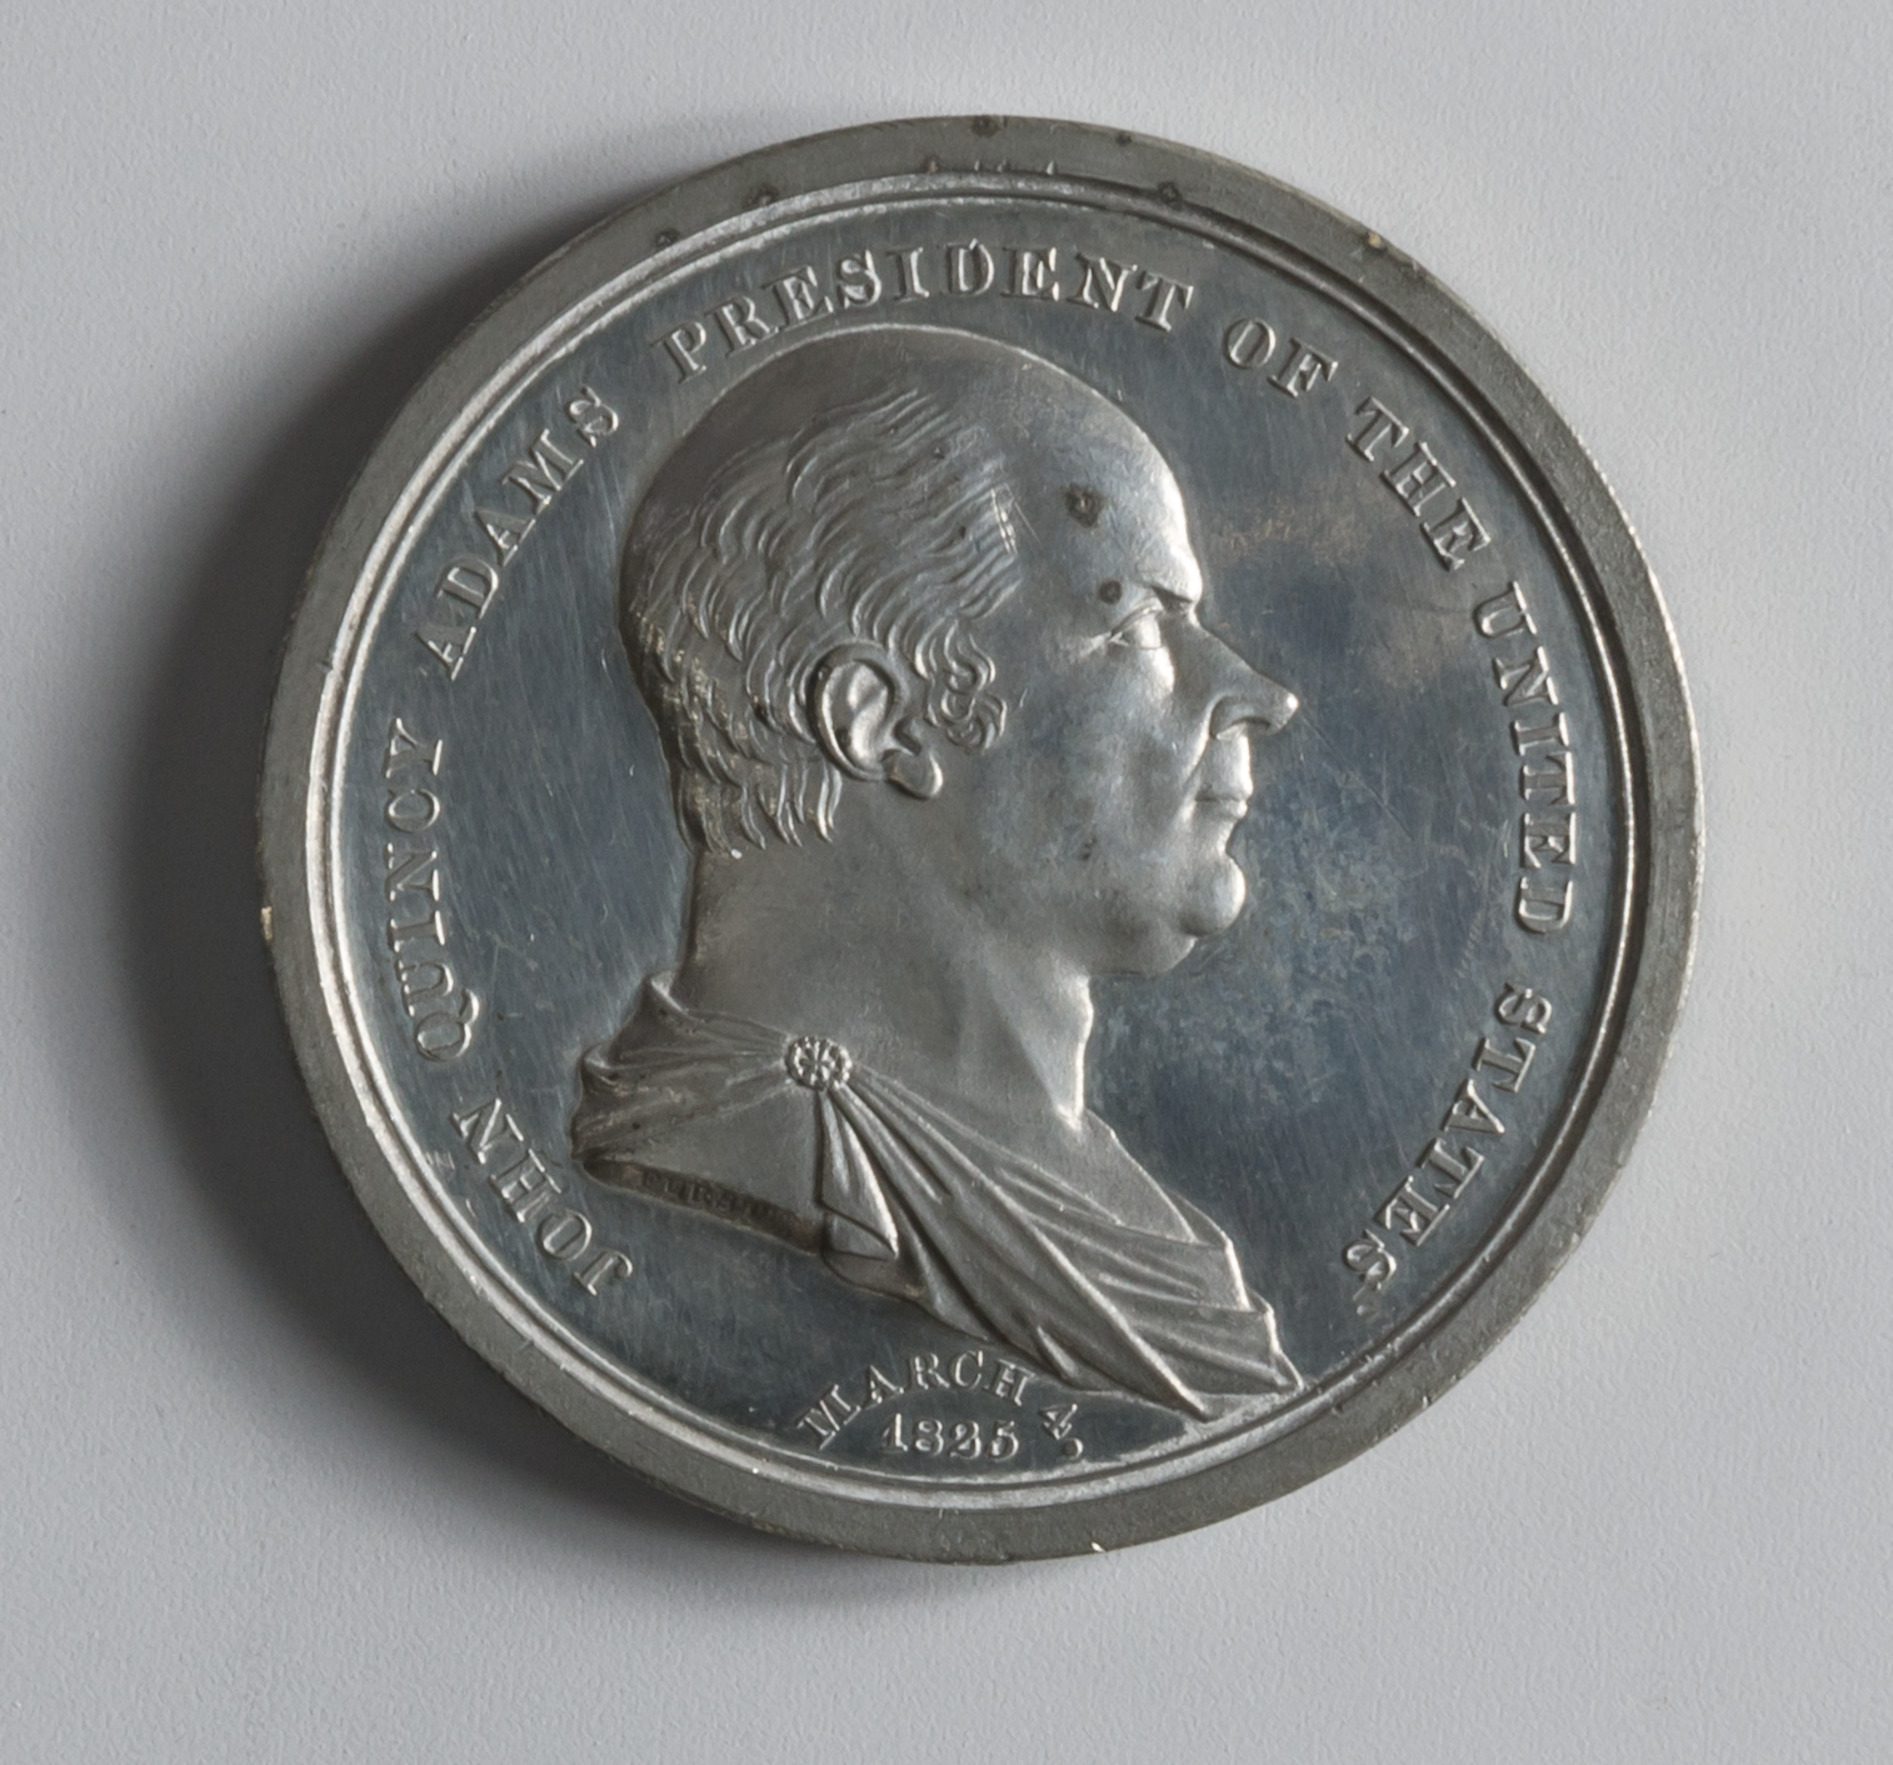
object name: medal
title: John Quincy Adams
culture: american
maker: moritz fürst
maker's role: artist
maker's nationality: hungarian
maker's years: 1782-1882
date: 1825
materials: silver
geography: united states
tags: profiles